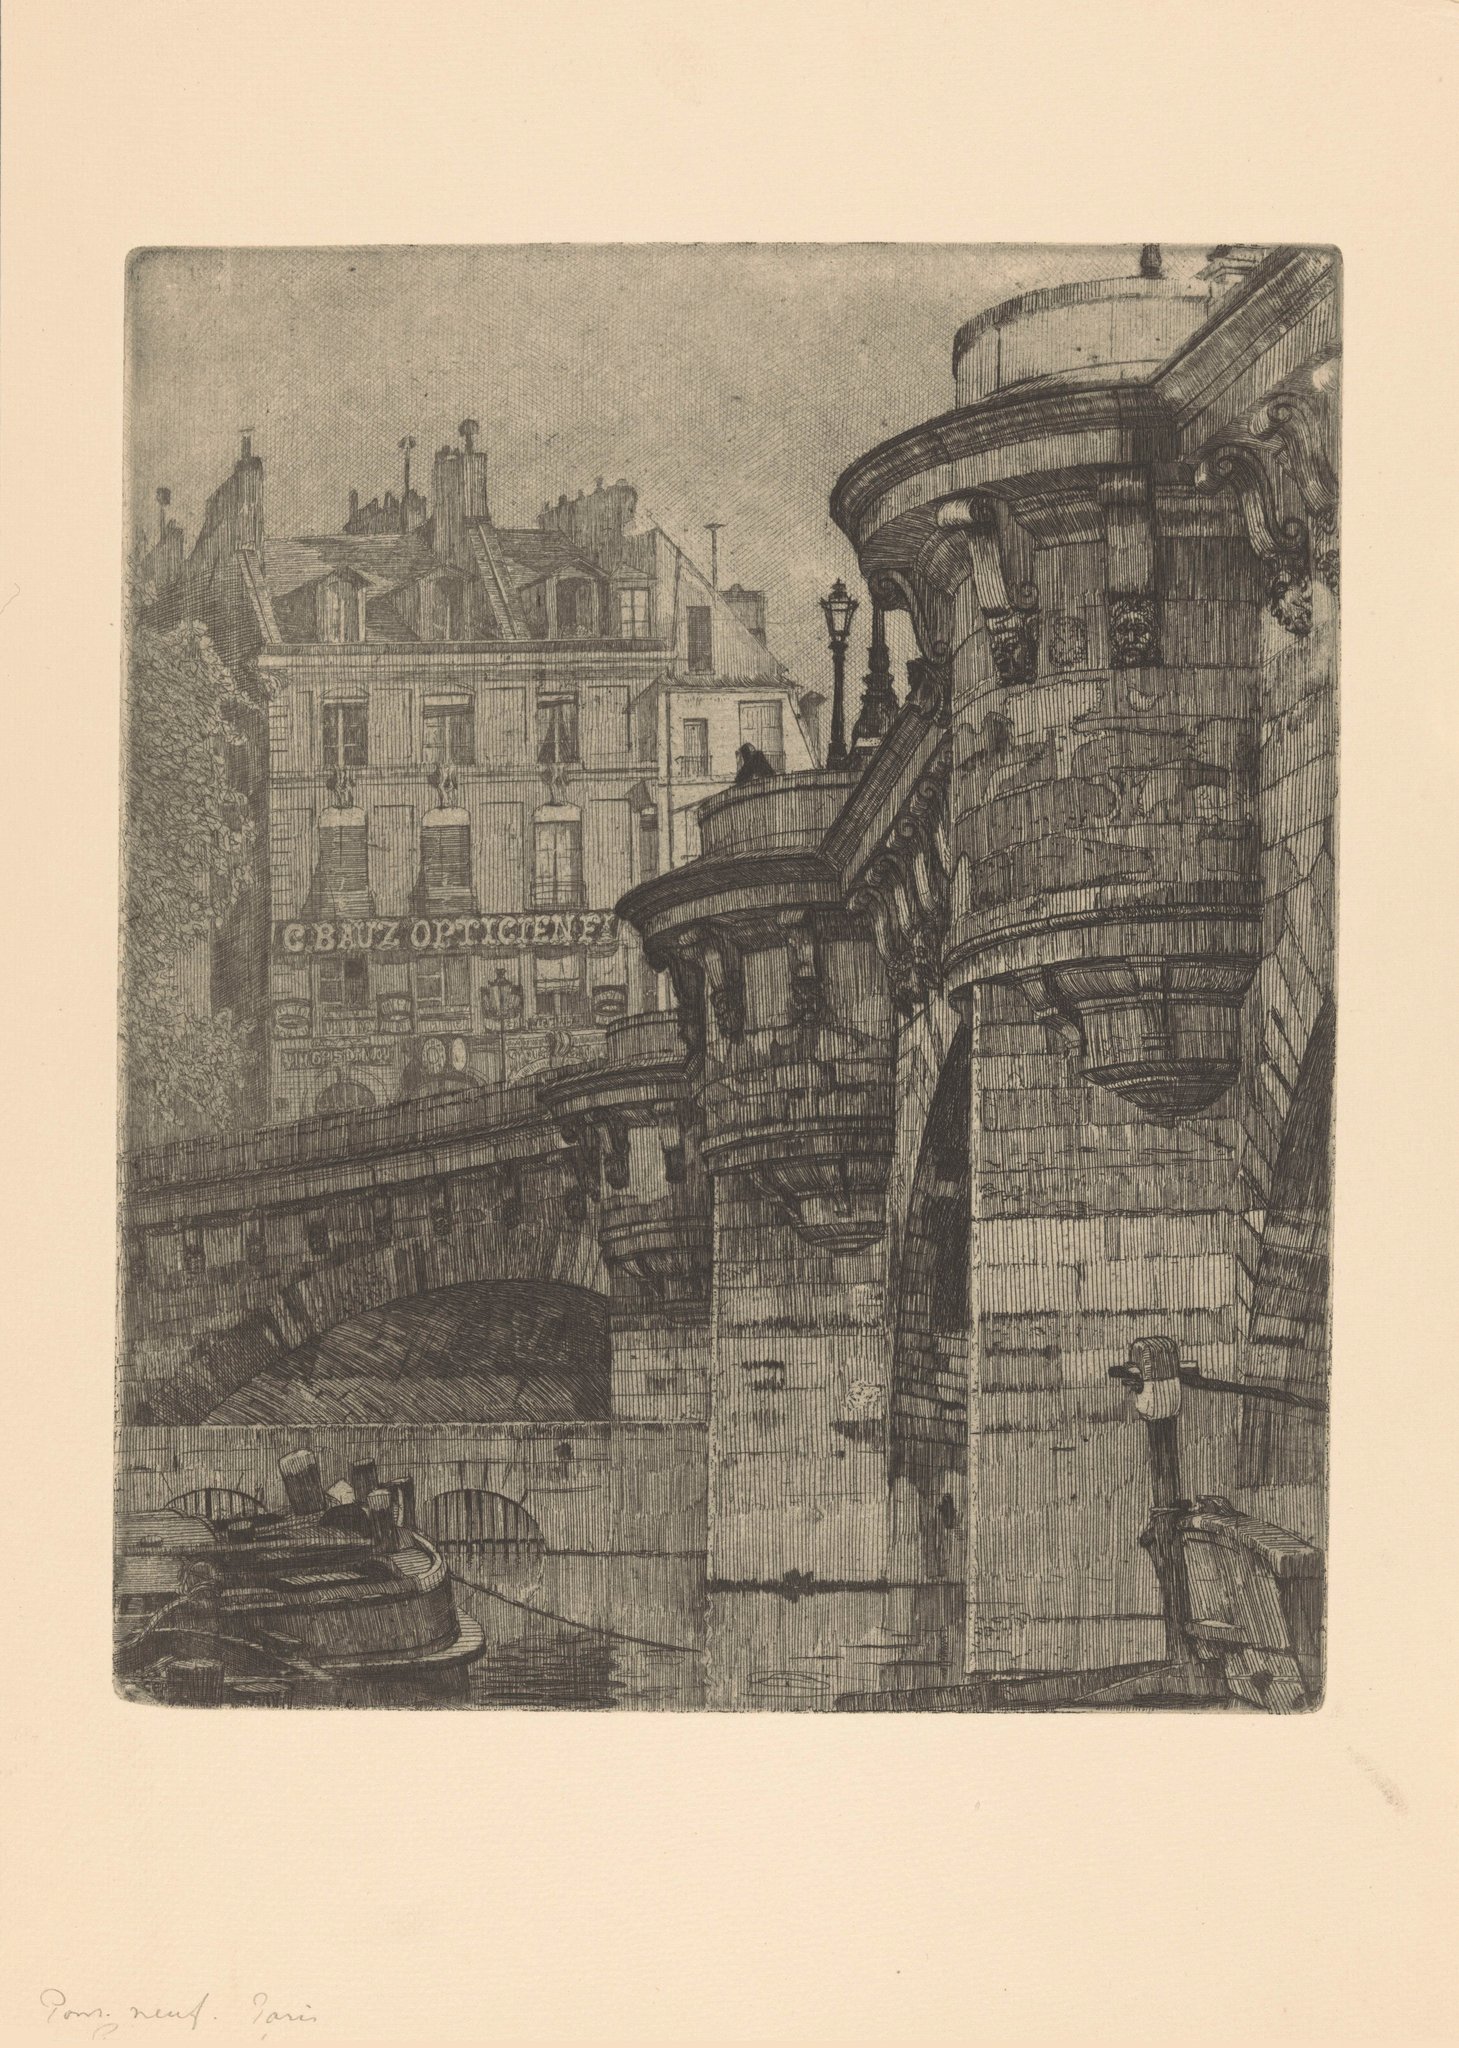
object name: print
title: Pont Neuf in Parijs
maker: martin monnickendam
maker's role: draughtsman, painter, print maker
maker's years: 1874-1943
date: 1896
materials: paper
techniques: etching, intaglio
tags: bridge in city across river, canal, etc.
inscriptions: collector's mark: Lugt 2228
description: Gezicht op de brug vanaf het water gezien.